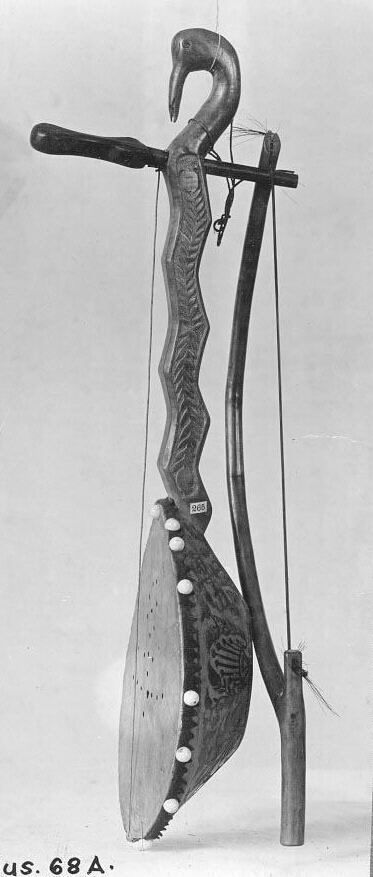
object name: gusle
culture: bulgarian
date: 1801-1900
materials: hair, wood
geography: bulgaria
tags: birds